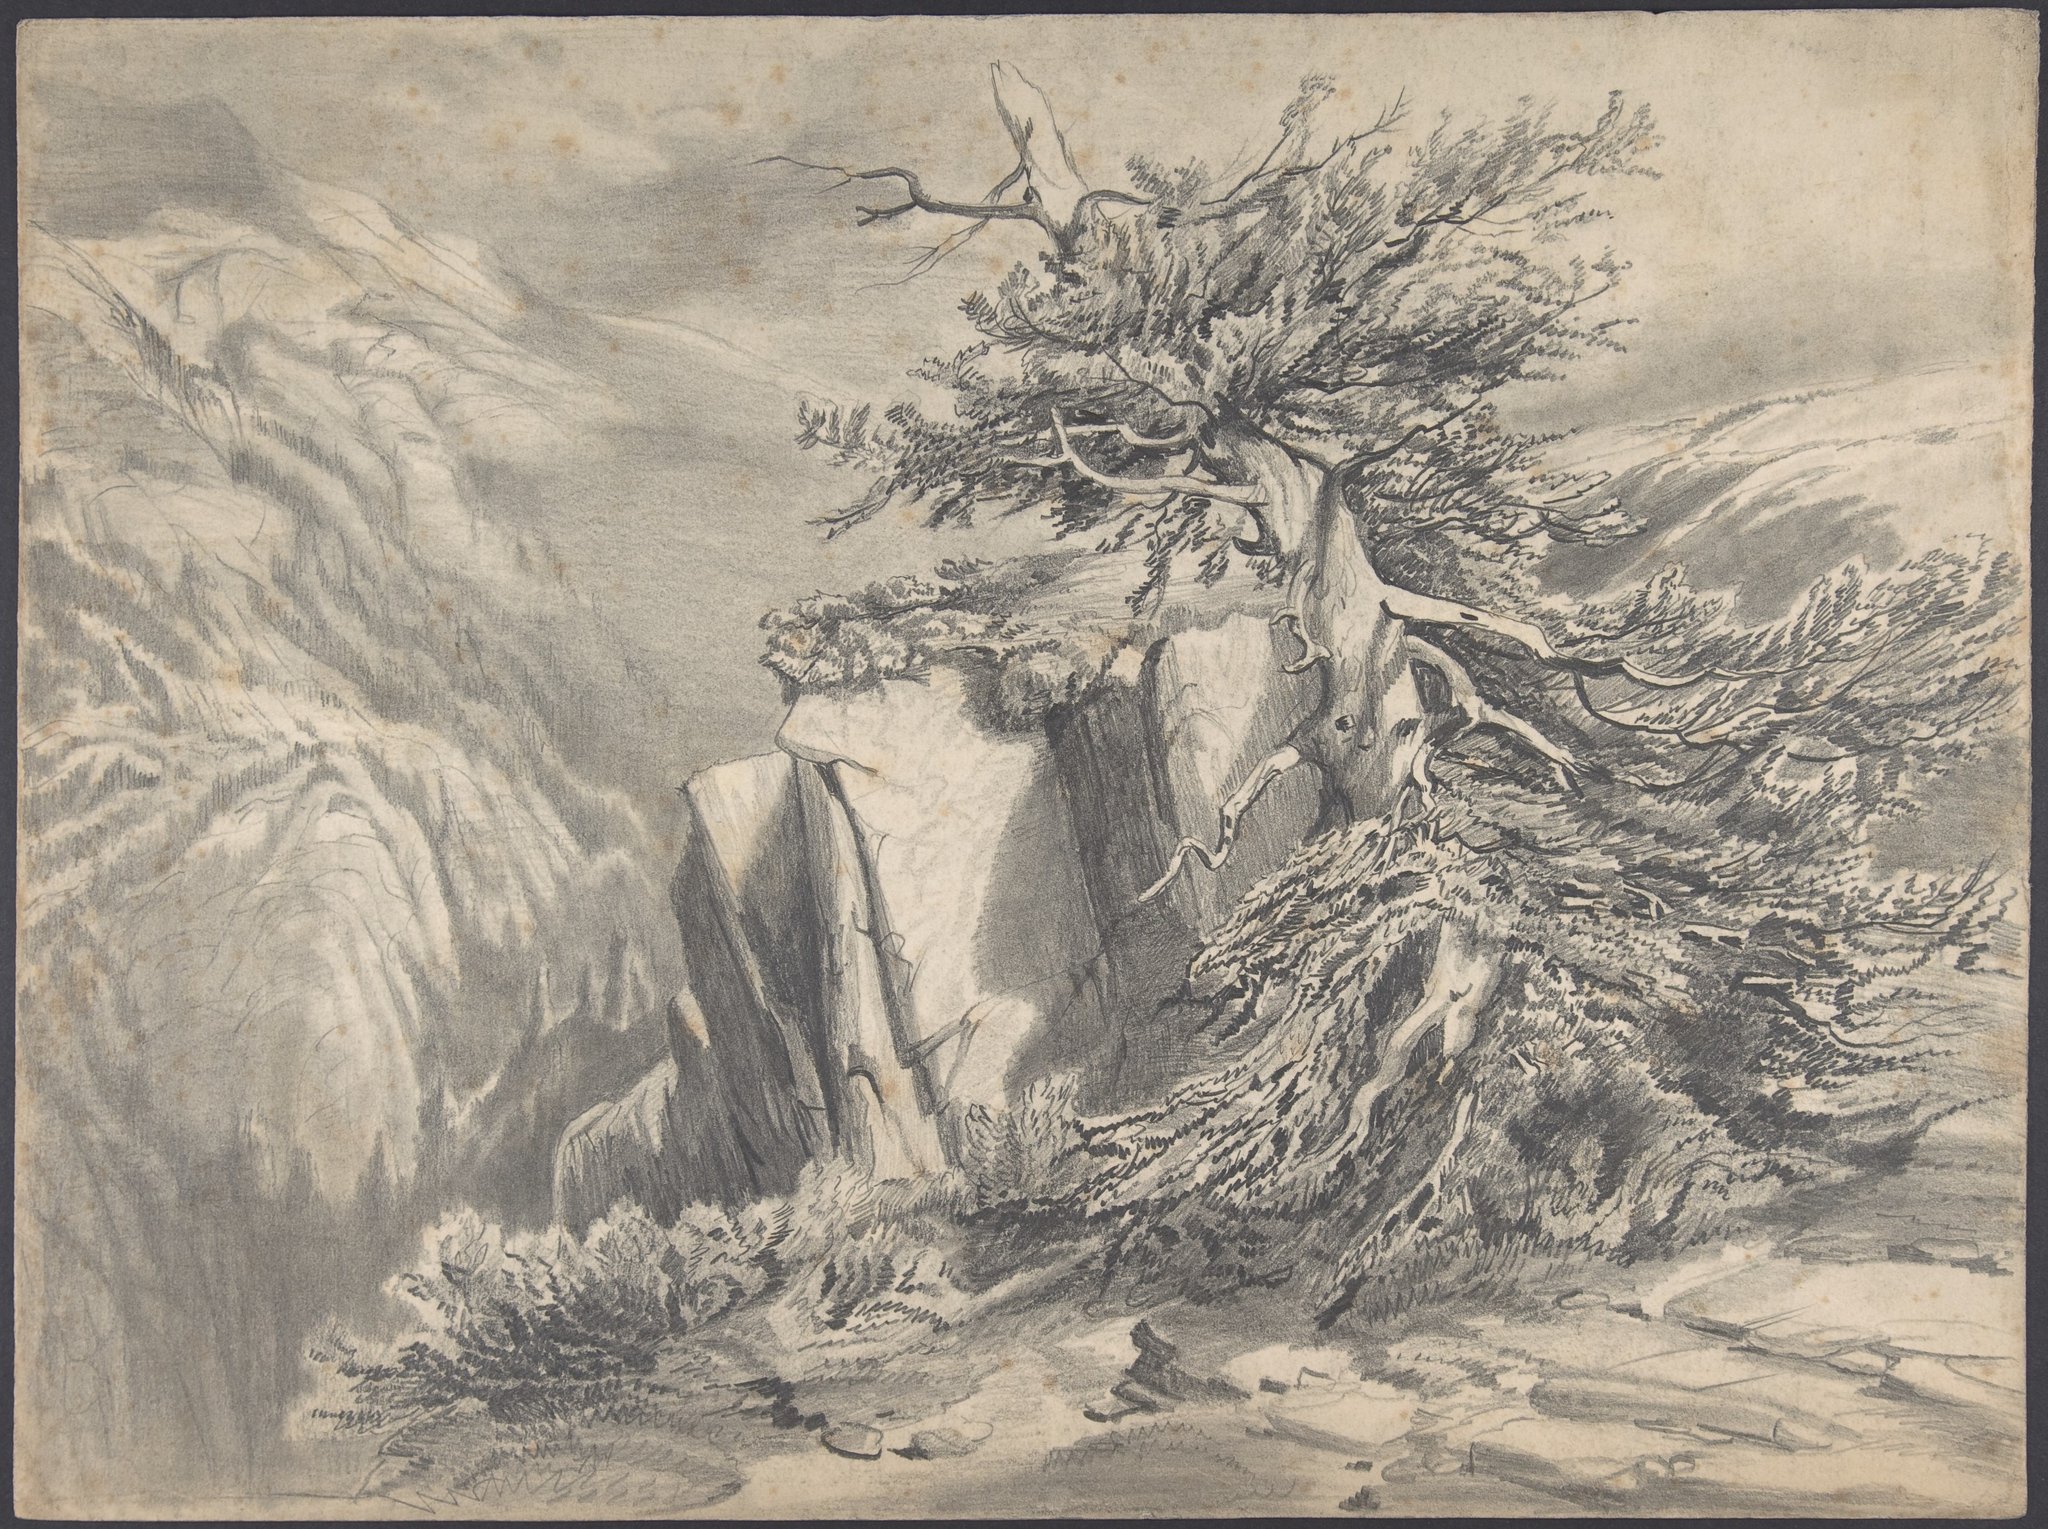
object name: drawing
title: Broken Tree in Moutainous Landscape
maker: alexandre calame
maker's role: artist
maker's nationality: swiss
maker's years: 1810-1864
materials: graphite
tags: mountains,landscapes,trees